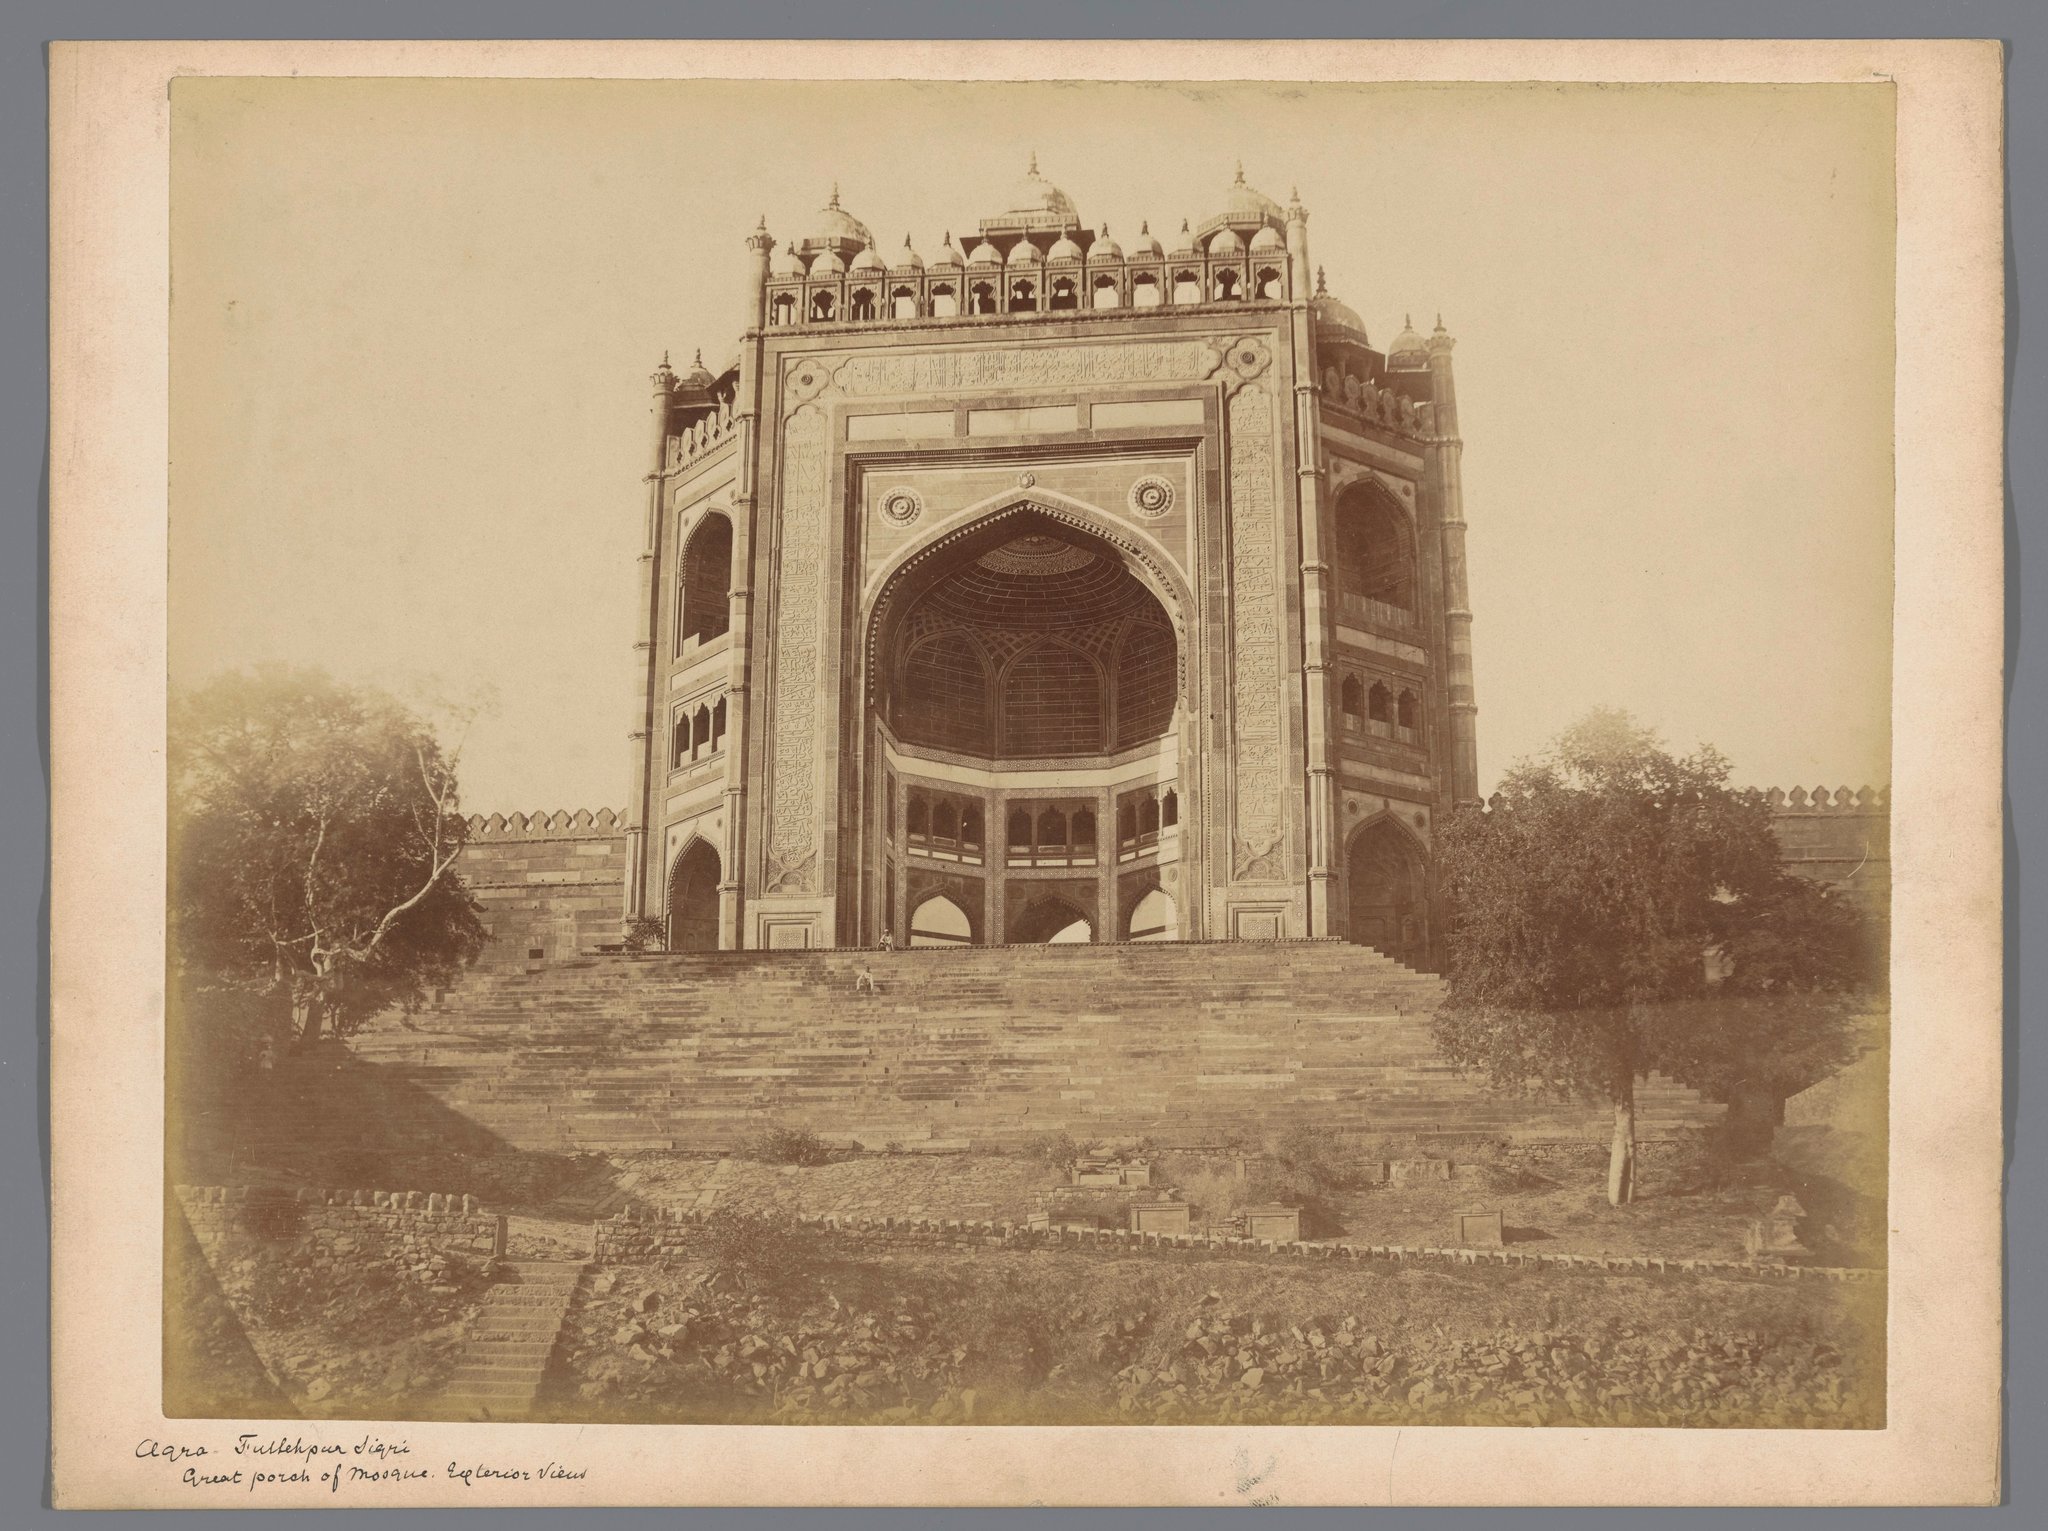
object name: photograph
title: View of the Buland Darwaza at Fatehpur Sikri, Uttar Pradesh, India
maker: Anonymous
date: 1865-1890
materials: cardboard, paper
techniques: albumen print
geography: fatehpur sikri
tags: gate, entrance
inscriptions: number: ‘60’, title: ‘Agra - Futtehpur Siqri/ Great porch of Mosque. Exterior View’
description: Buland Darwaza is de hoogste toegangspoort ter wereld.